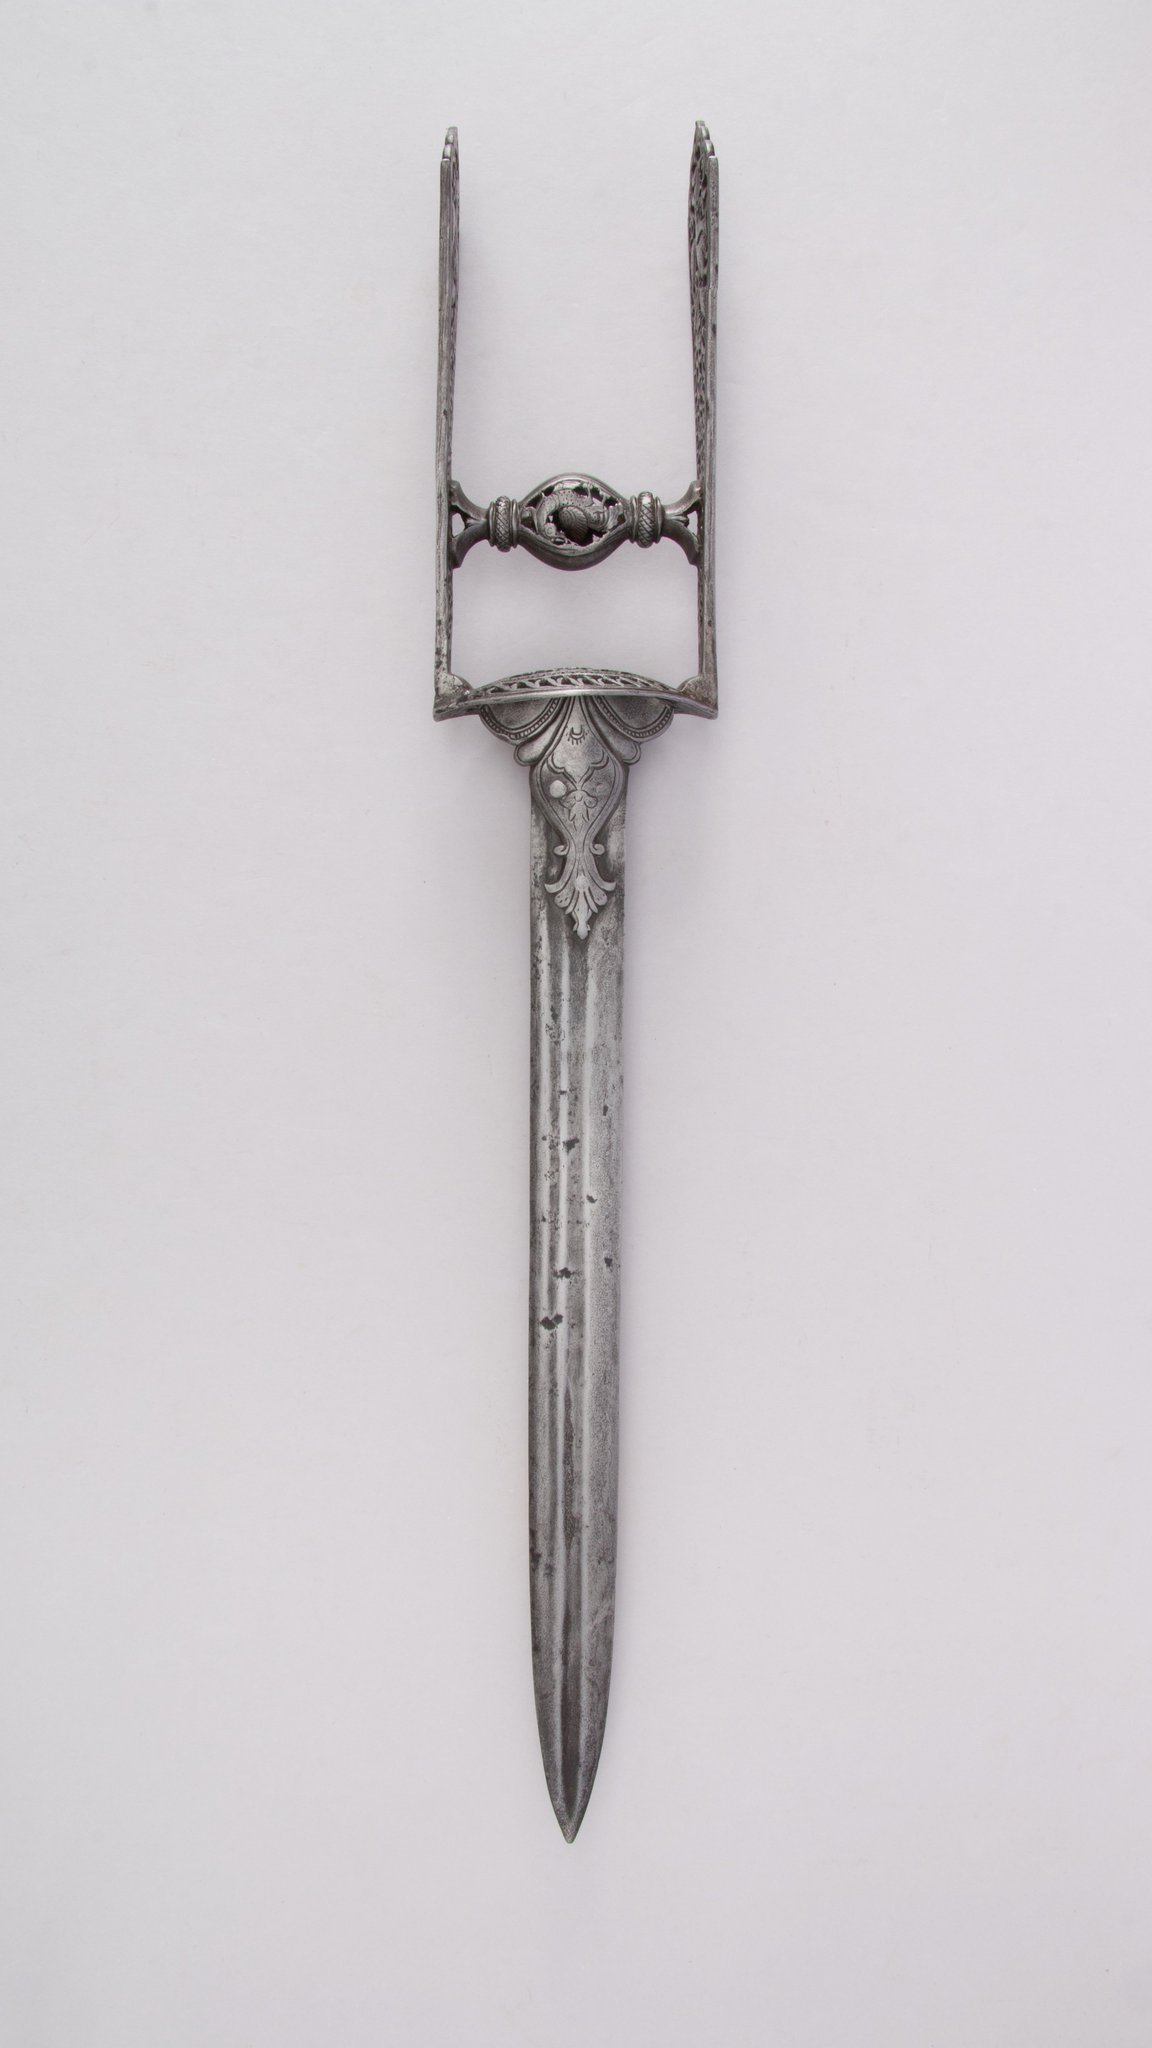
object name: dagger katar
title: Dagger (Katar)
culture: indian or european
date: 1601-1700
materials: steel